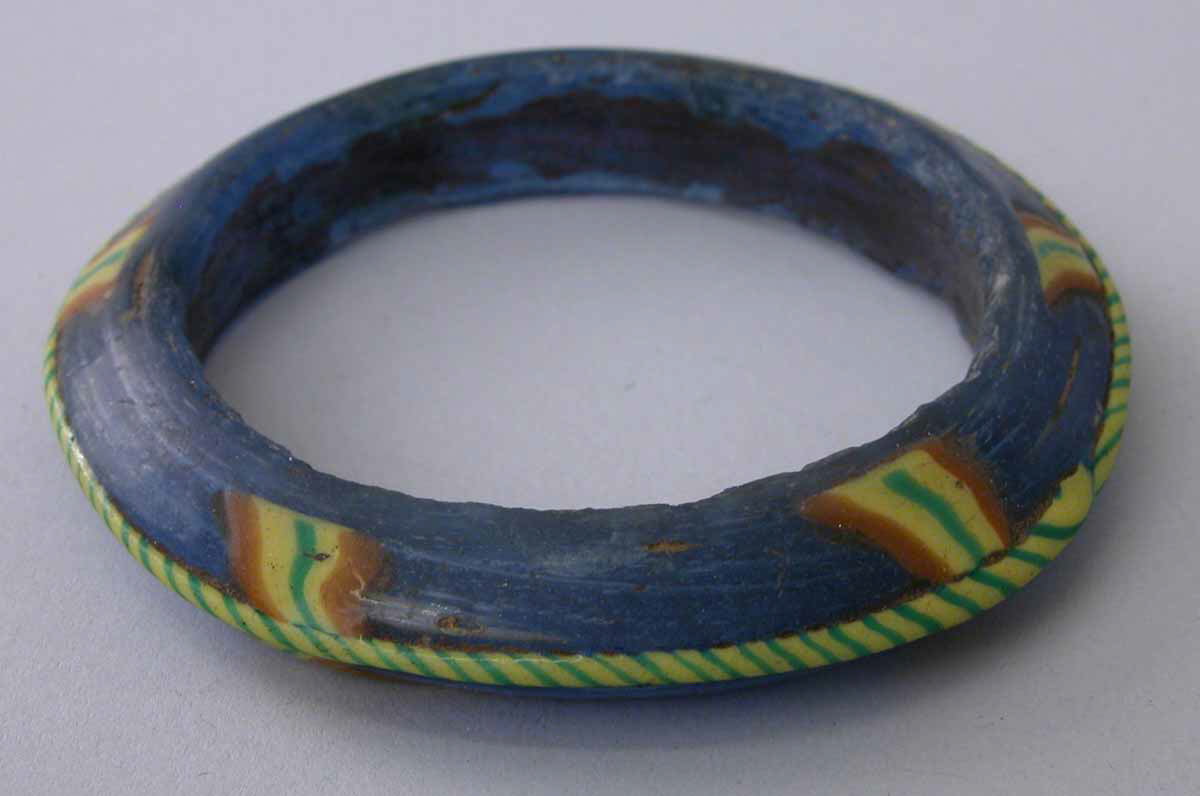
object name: bracelet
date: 1301-1500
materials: glass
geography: egypt or syria